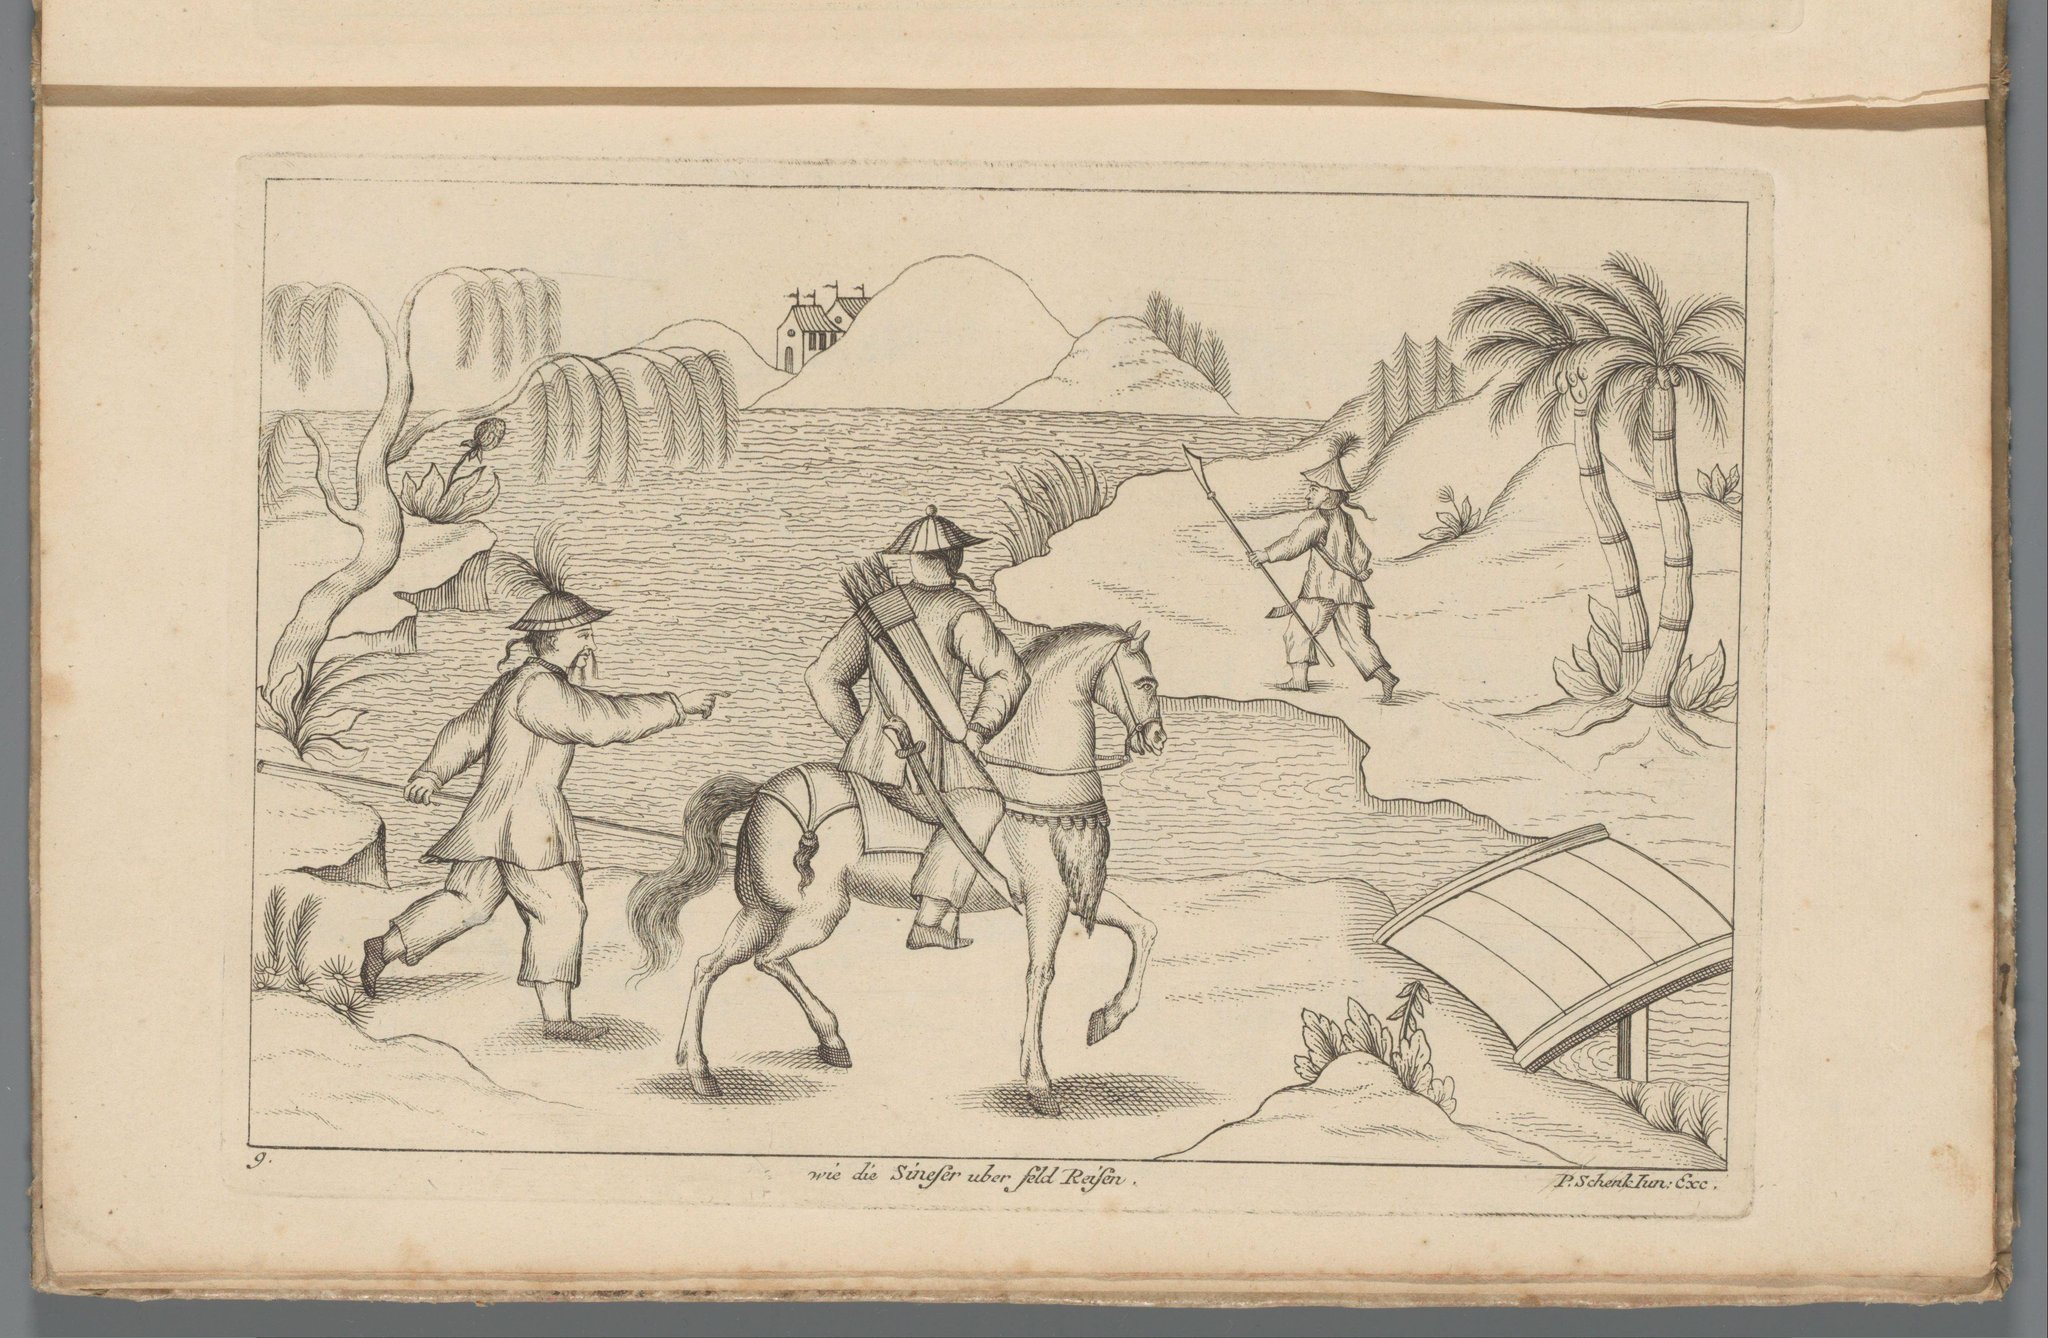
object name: album leaf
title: Chinese gebruiken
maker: pieter schenk (ii)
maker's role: draughtsman, print maker, publisher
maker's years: 1693-1775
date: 1727-1775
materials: paper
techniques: etching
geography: amsterdam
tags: riding a horse, ass, or mule; rider, horseman, chinese, landscapes in the temperate zone, 'en route', traveller under way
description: Landschap met drie Chinese reizigers. Twee gaan te voet, één reist te paard. Prent maakt deel uit van een album.